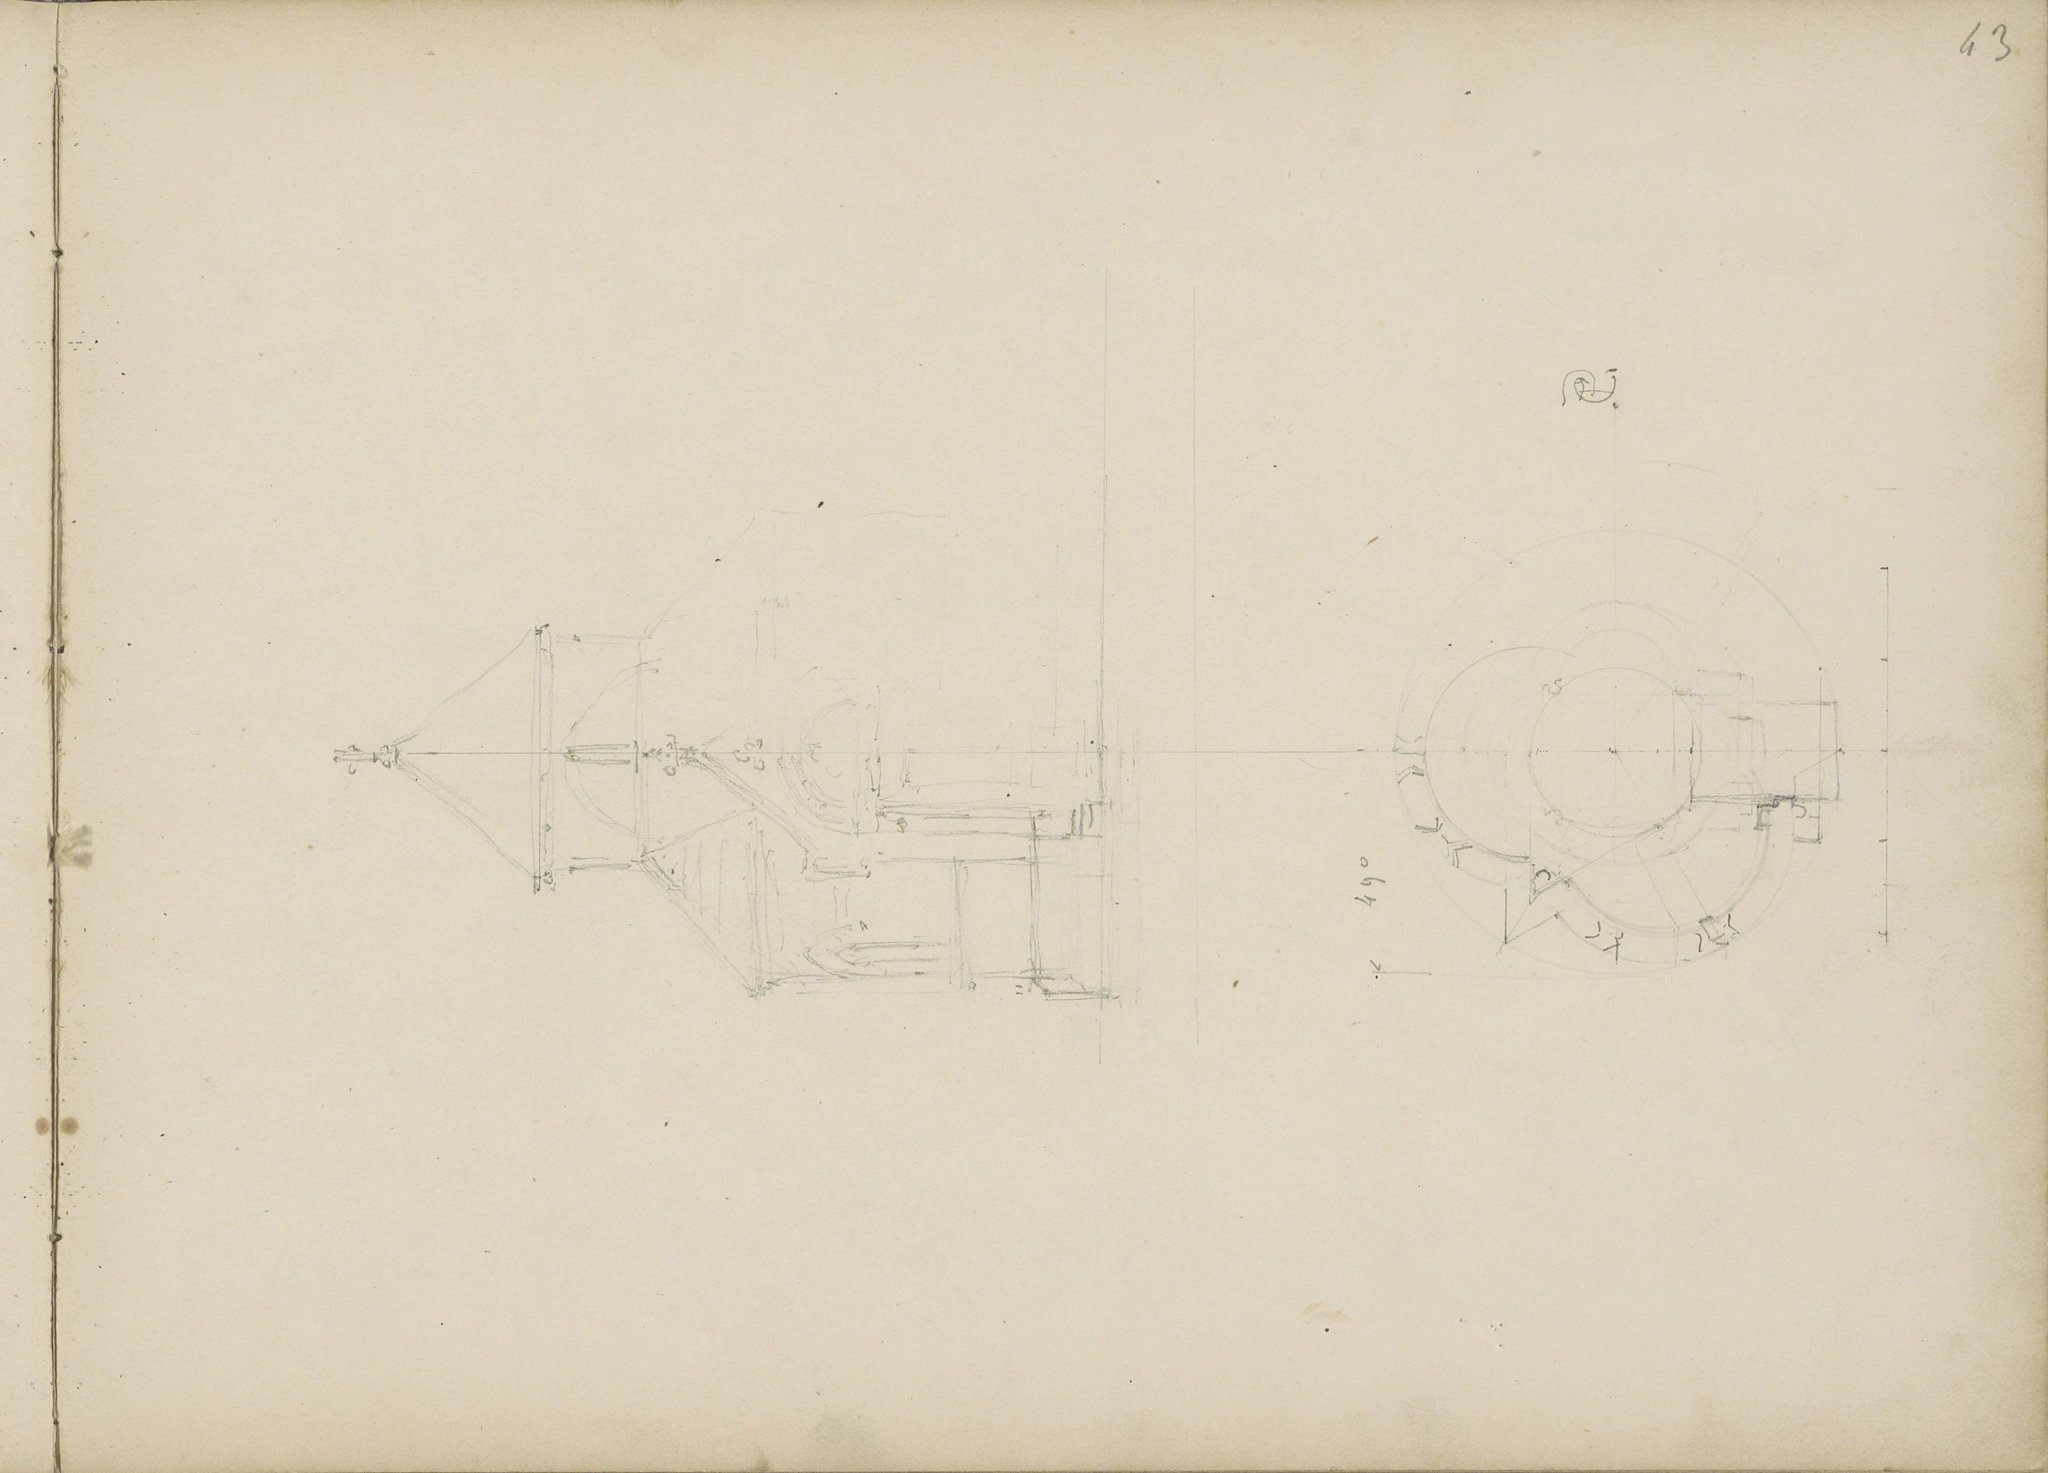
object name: sketchbook leaf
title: Voor- en bovenaanzicht van de Bisschoppelijke Grafkapel te Roermond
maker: pierre joseph hubert cuypers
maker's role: draughtsman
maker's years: 1827-1921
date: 1857-1859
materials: paper, pencil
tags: church (exterior) - qq - small church, chapel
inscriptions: annotation: ‘490’, monogram: ‘PC’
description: Voor ontwerpschetsen van de koorzijde, doorsneden en een plattegrond zie de verwijzing in documentatie.